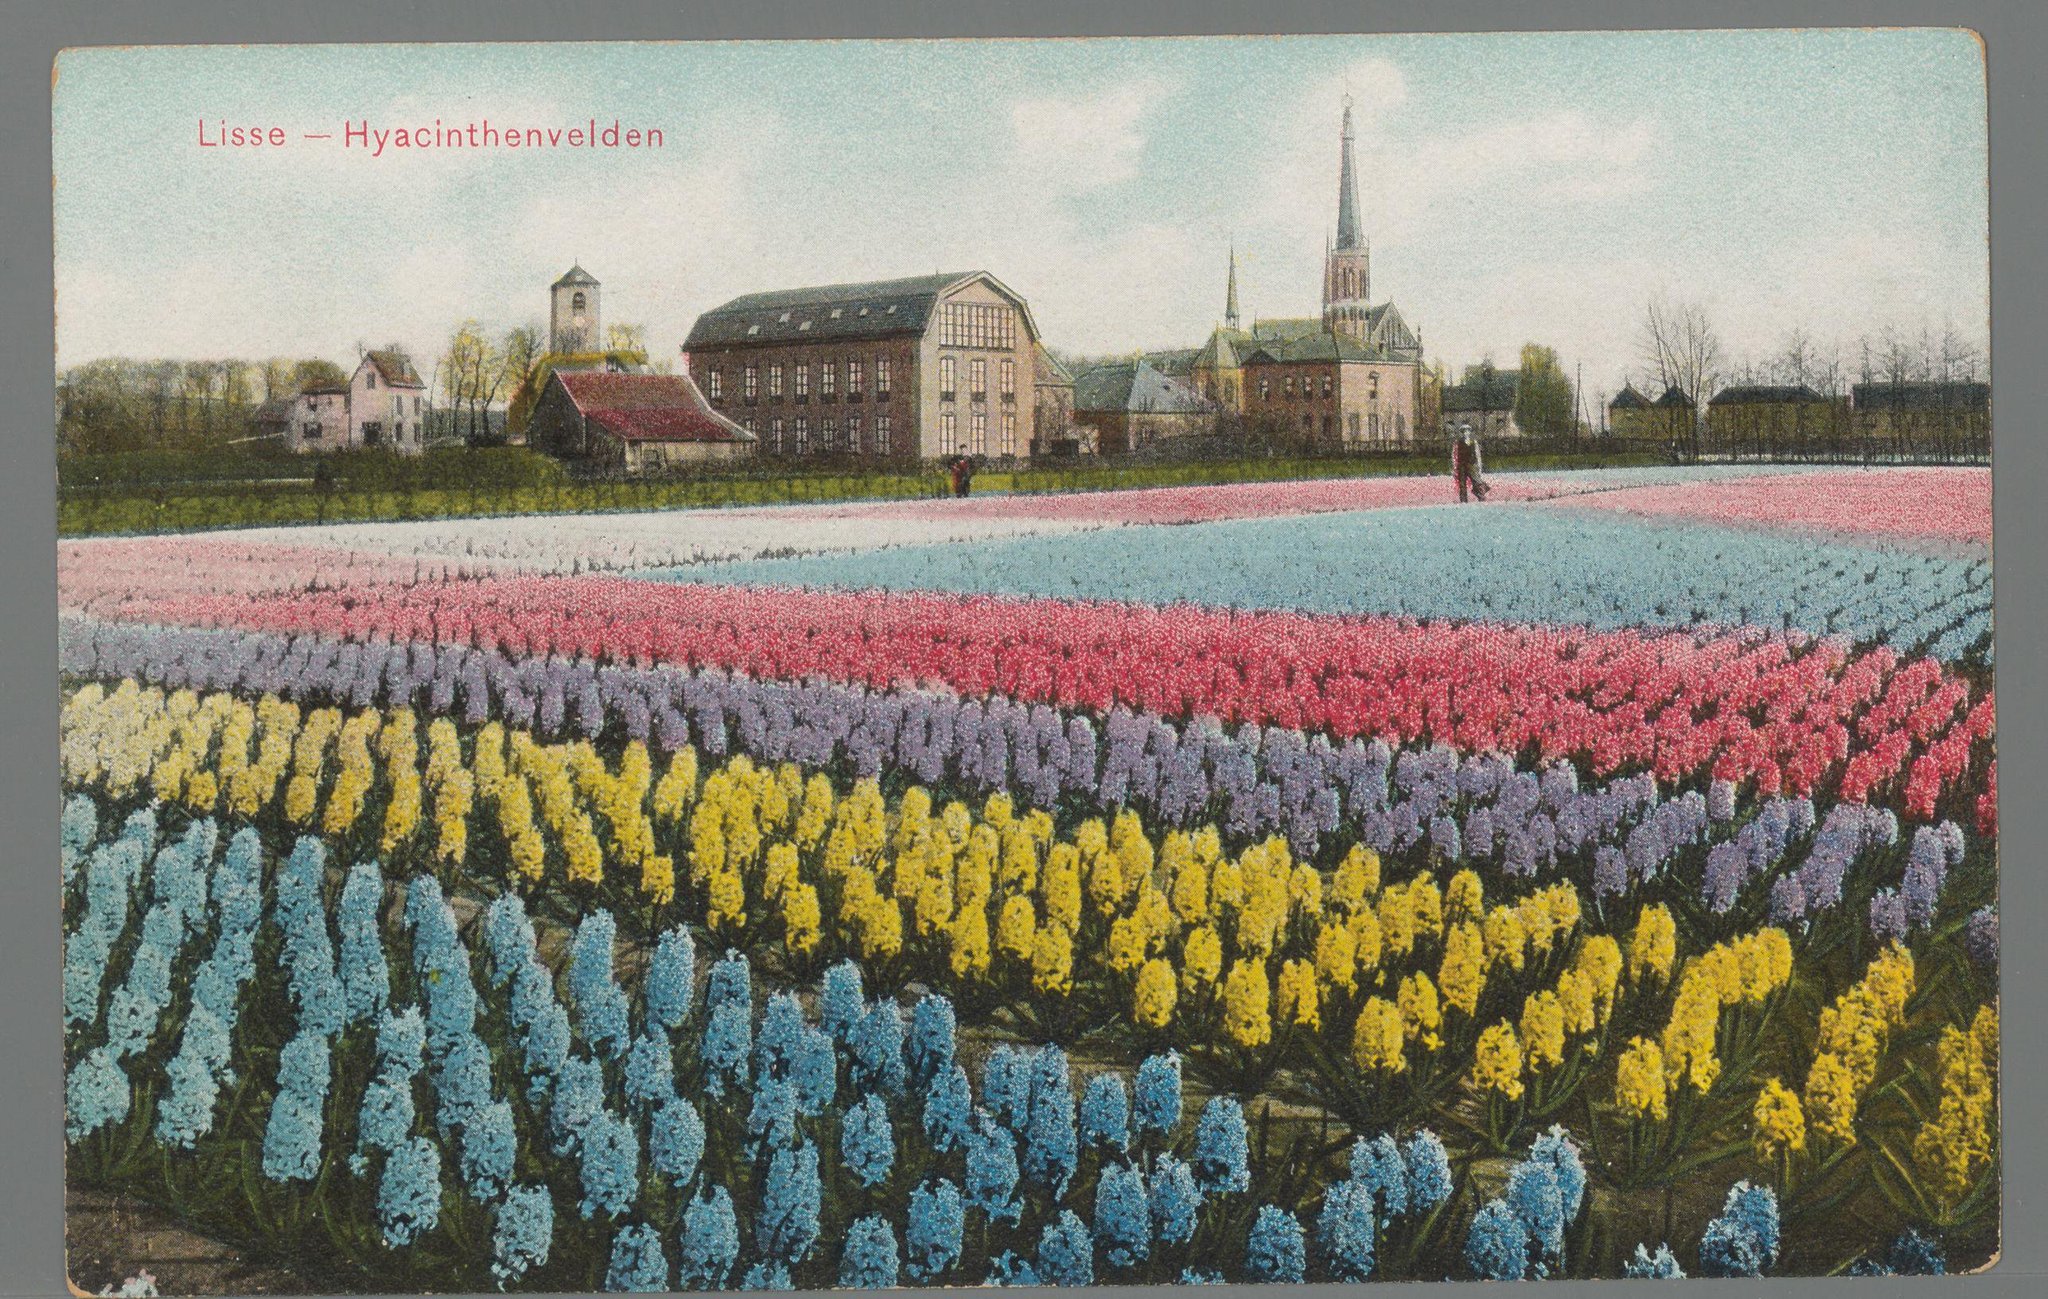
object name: photomechanical print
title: Lisse - hyacinthenvelden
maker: Anonymous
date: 1907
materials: cardboard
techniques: lithograph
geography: leipzig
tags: bulb field, church (exterior)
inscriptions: date